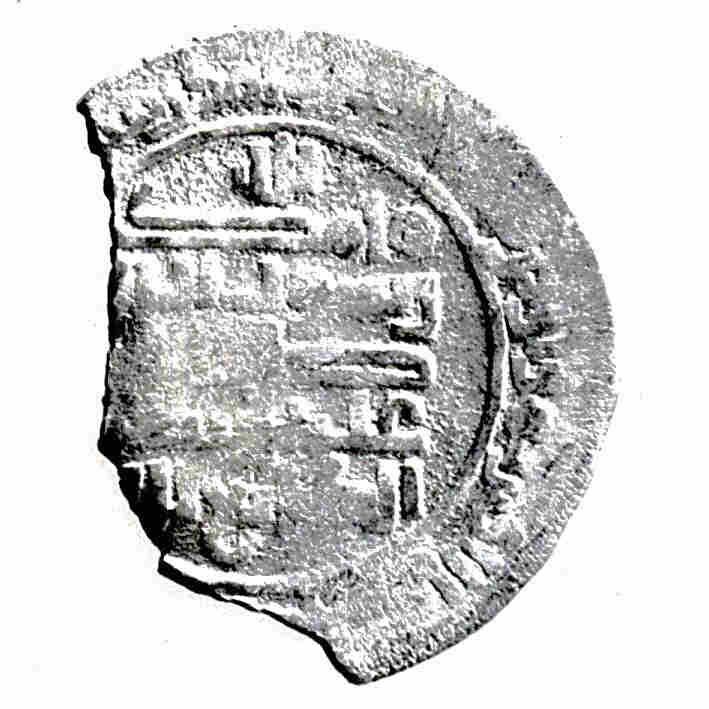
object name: coin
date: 977-982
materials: silver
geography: iran